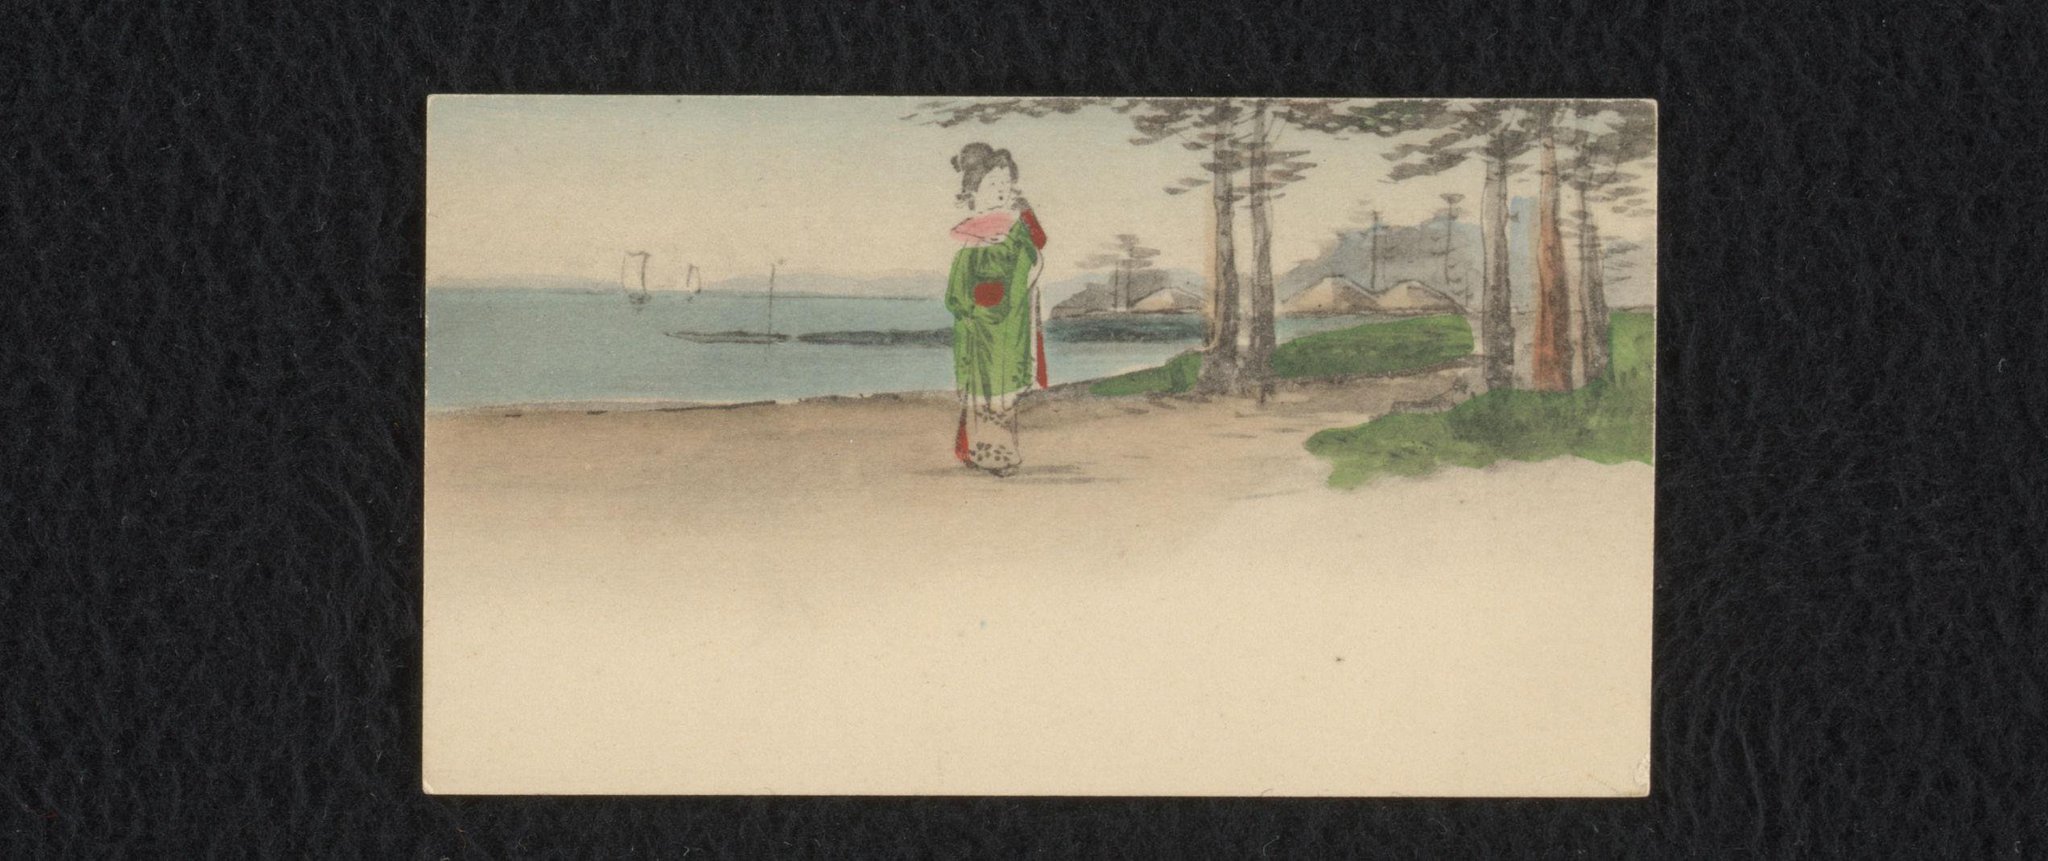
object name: visiting card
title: Reproductie van een tekening van een Japanse vrouw aan een strand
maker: Anonymous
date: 1890-1920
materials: paper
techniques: photograph, lithograph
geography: japan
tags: adult woman, japan